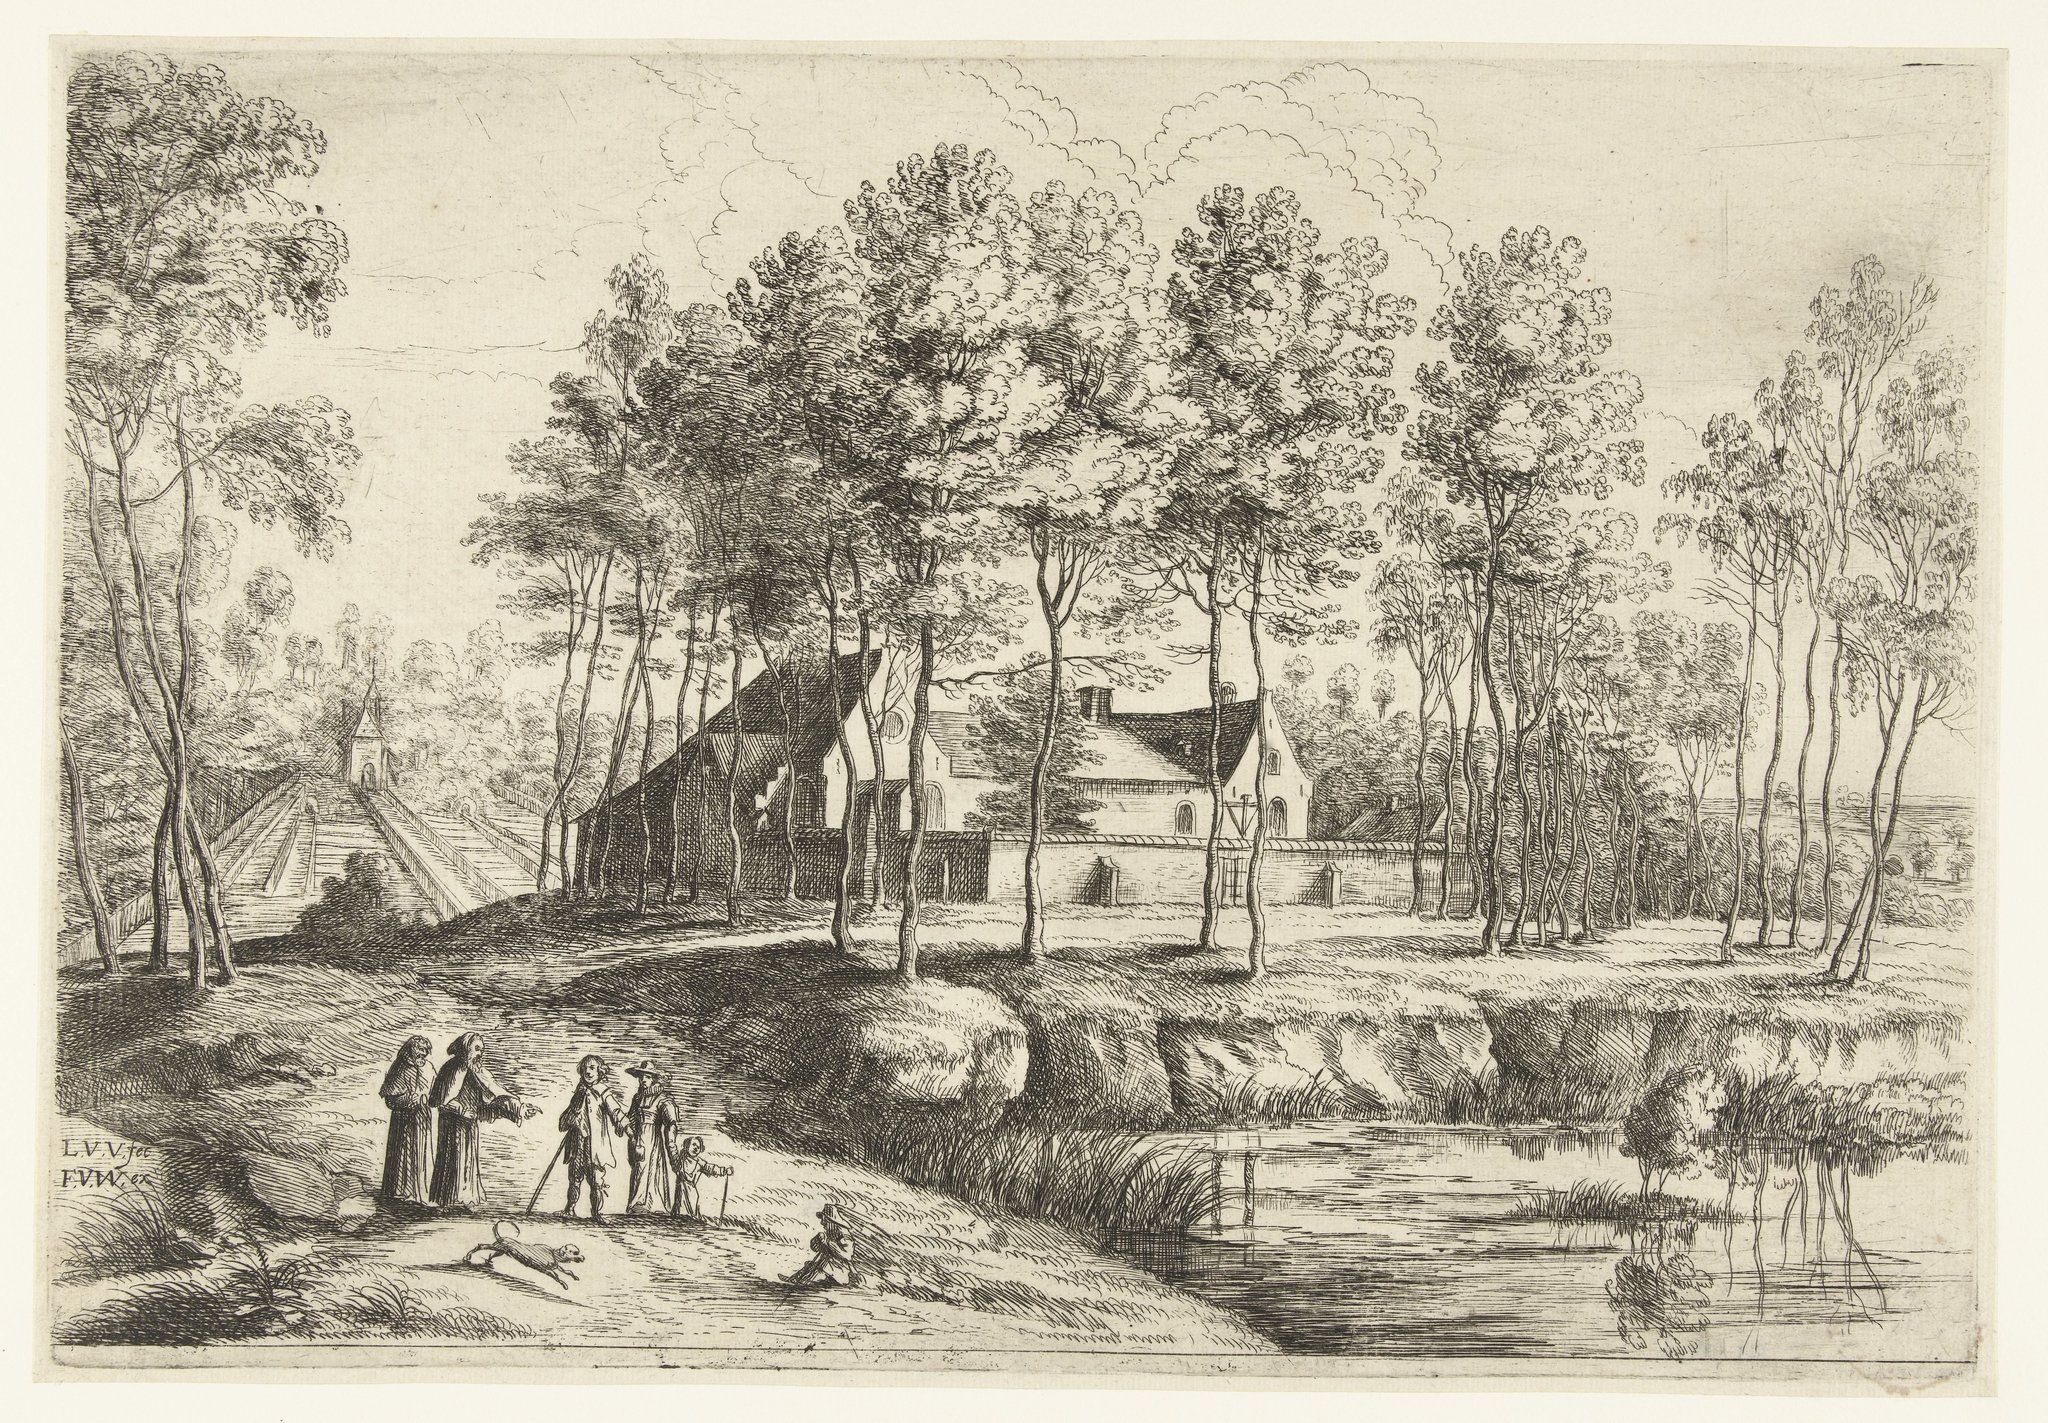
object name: print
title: Gezicht op het kapucijnenklooster te Tervueren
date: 1605-1673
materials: paper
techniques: engraving, etching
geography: low countries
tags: cloisters ~ monastery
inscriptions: collector's mark: Lugt 240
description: Het kapucijnenklooster met kloostertuin aan een landweg met bomen. Zes mensen en een hond op de weg.